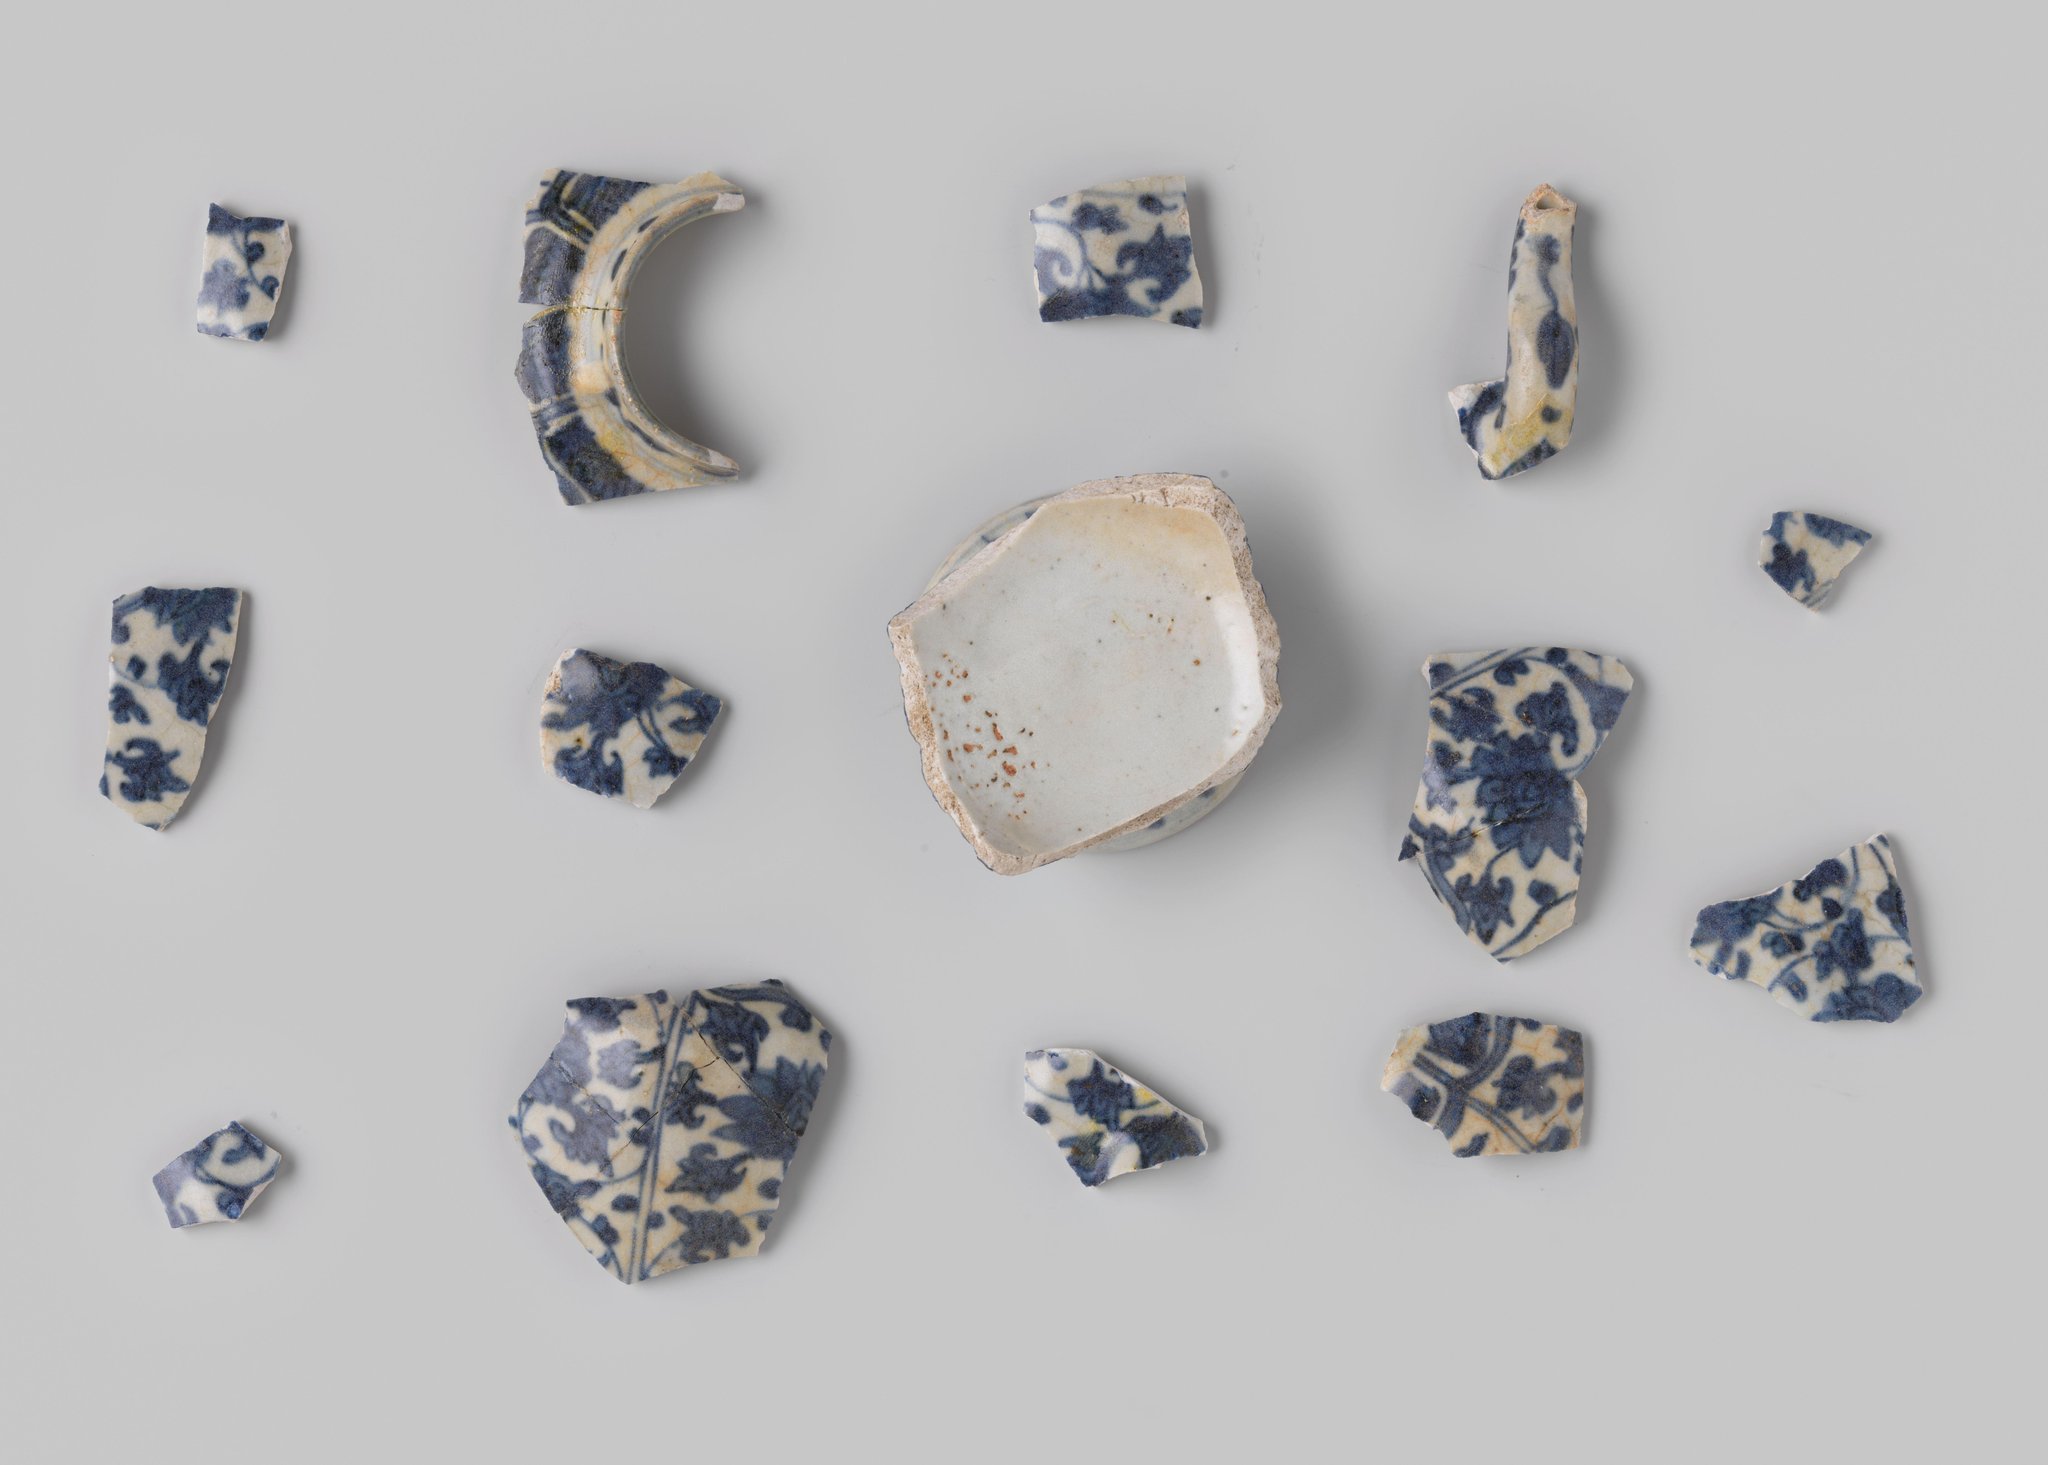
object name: sherd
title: Scherven van een wijnkan uit V.O.C.-schip de 'Witte Leeuw'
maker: Anonymous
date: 1613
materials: porcelain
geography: jingdezhen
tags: verenigde oostindische compagnie, sint-helena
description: A dish with a flattened rim. On the flat is round design of flowers (a.o. chrysanthemums) and plants, encircled by a single band. On the flattened rim are alternatively symbols and flowers. On the outside are four groups of flowers. On the rim groups of flowers and leaves with in between groups of four dots.